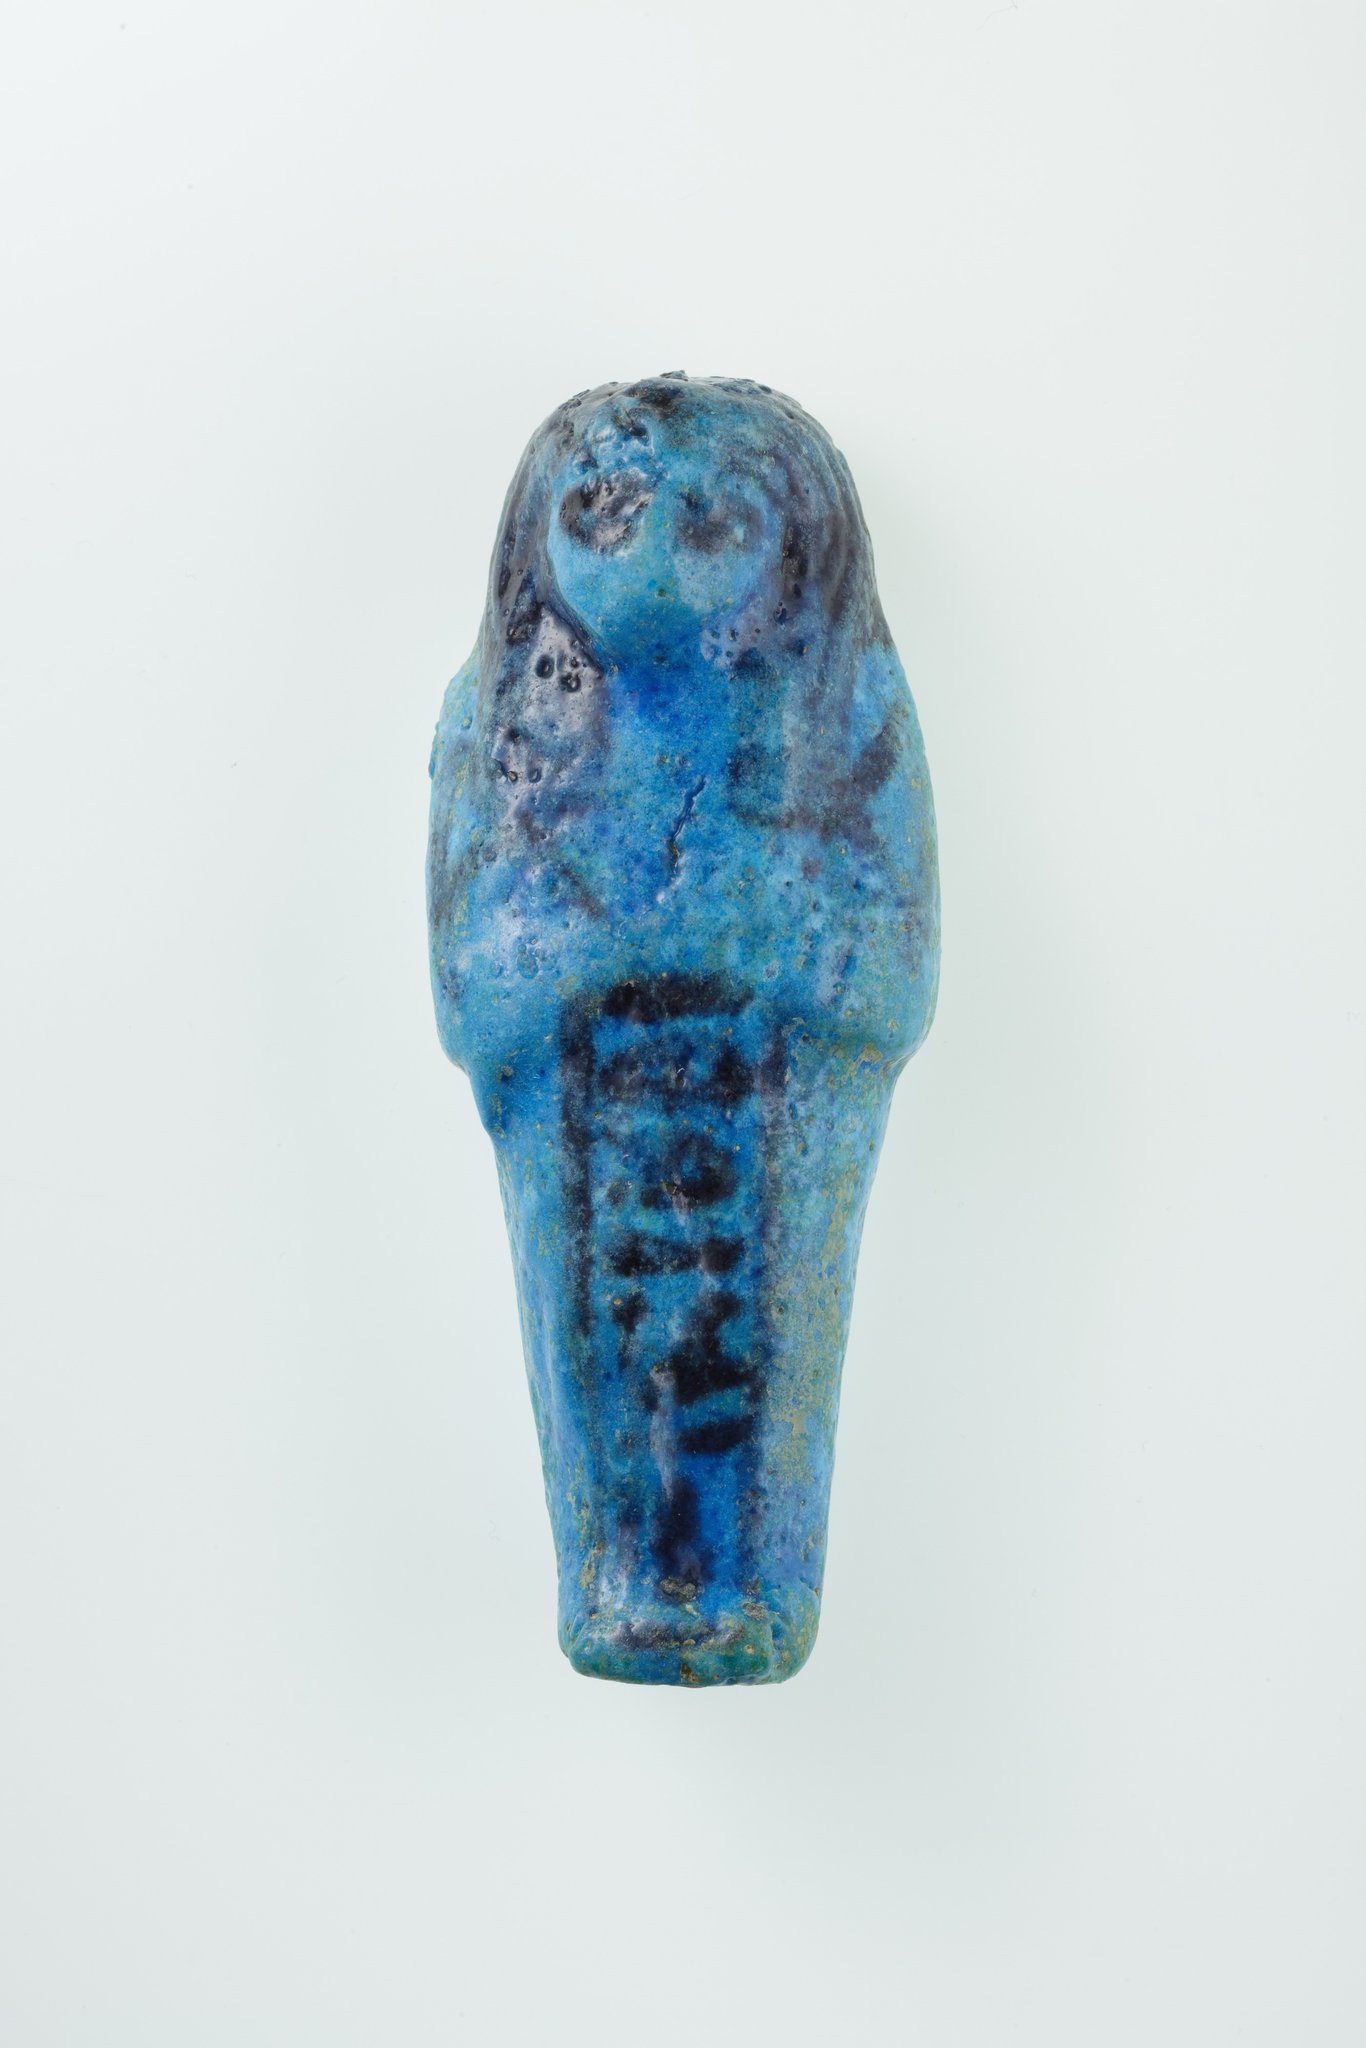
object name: shabti, worker, nauny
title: Worker Shabti of Nauny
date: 1050 BCE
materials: faience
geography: egypt